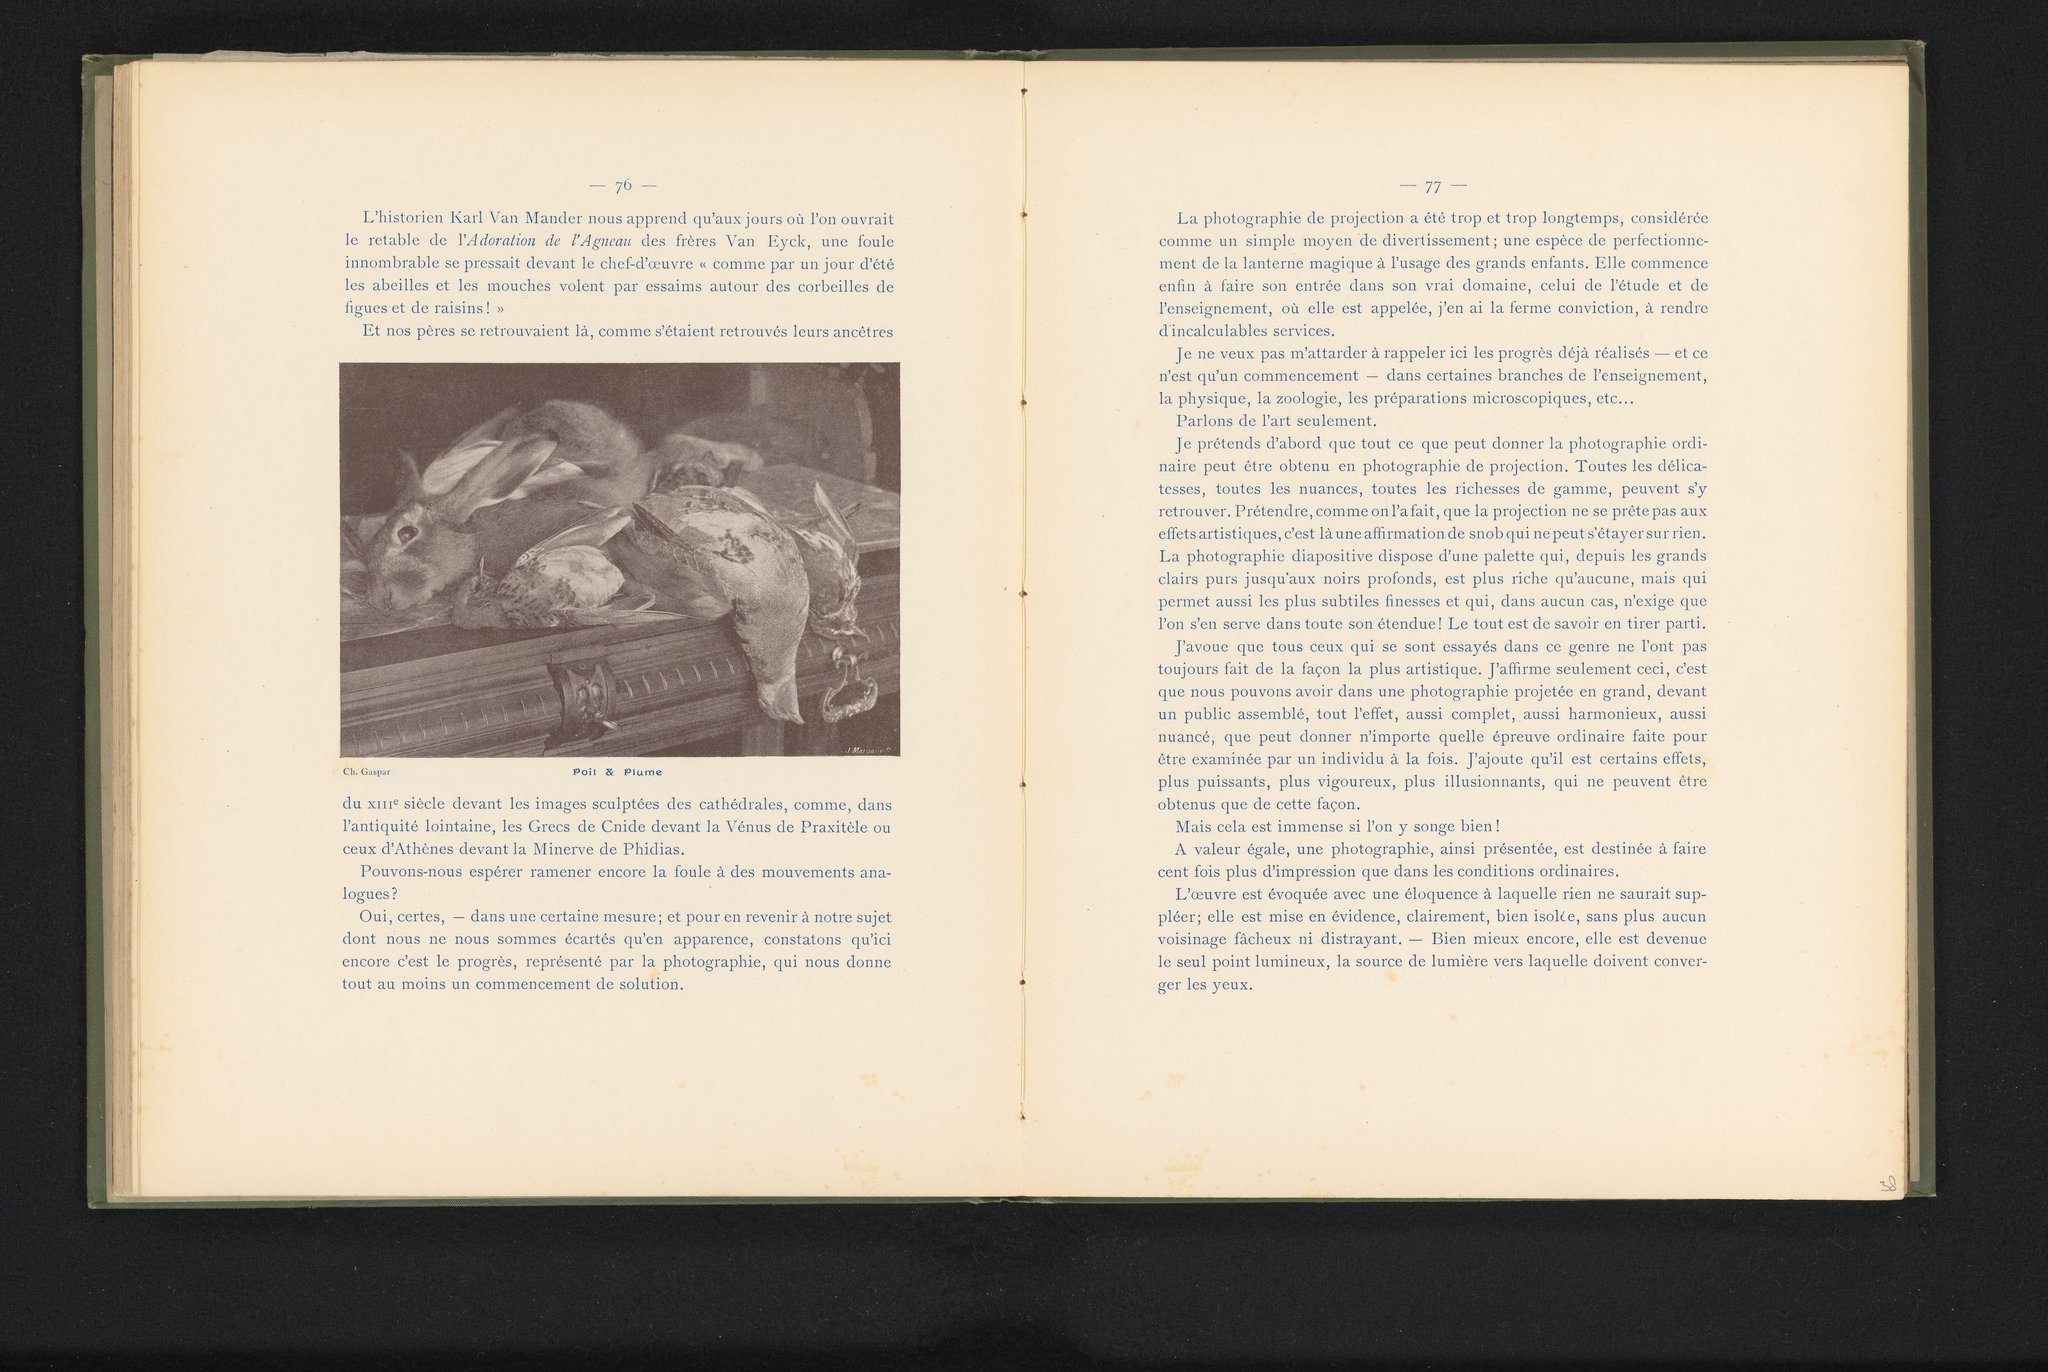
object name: photomechanical print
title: Stilleven met gevogelte en een haas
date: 1893-1898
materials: paper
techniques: autotype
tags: birds, rodents: hare, still life of related objects